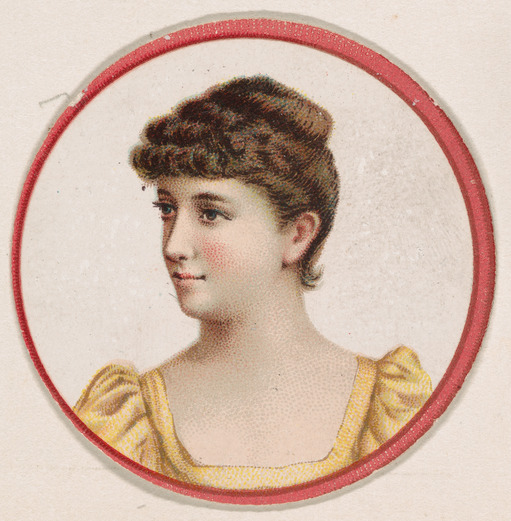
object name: print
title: Portrait of woman, from the Novelties series (N228, Type 2) issued by Kinney Bros.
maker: kinney brothers tobacco company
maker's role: publisher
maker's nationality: american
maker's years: 1869-2011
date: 1889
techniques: color lithograph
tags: portraits,women